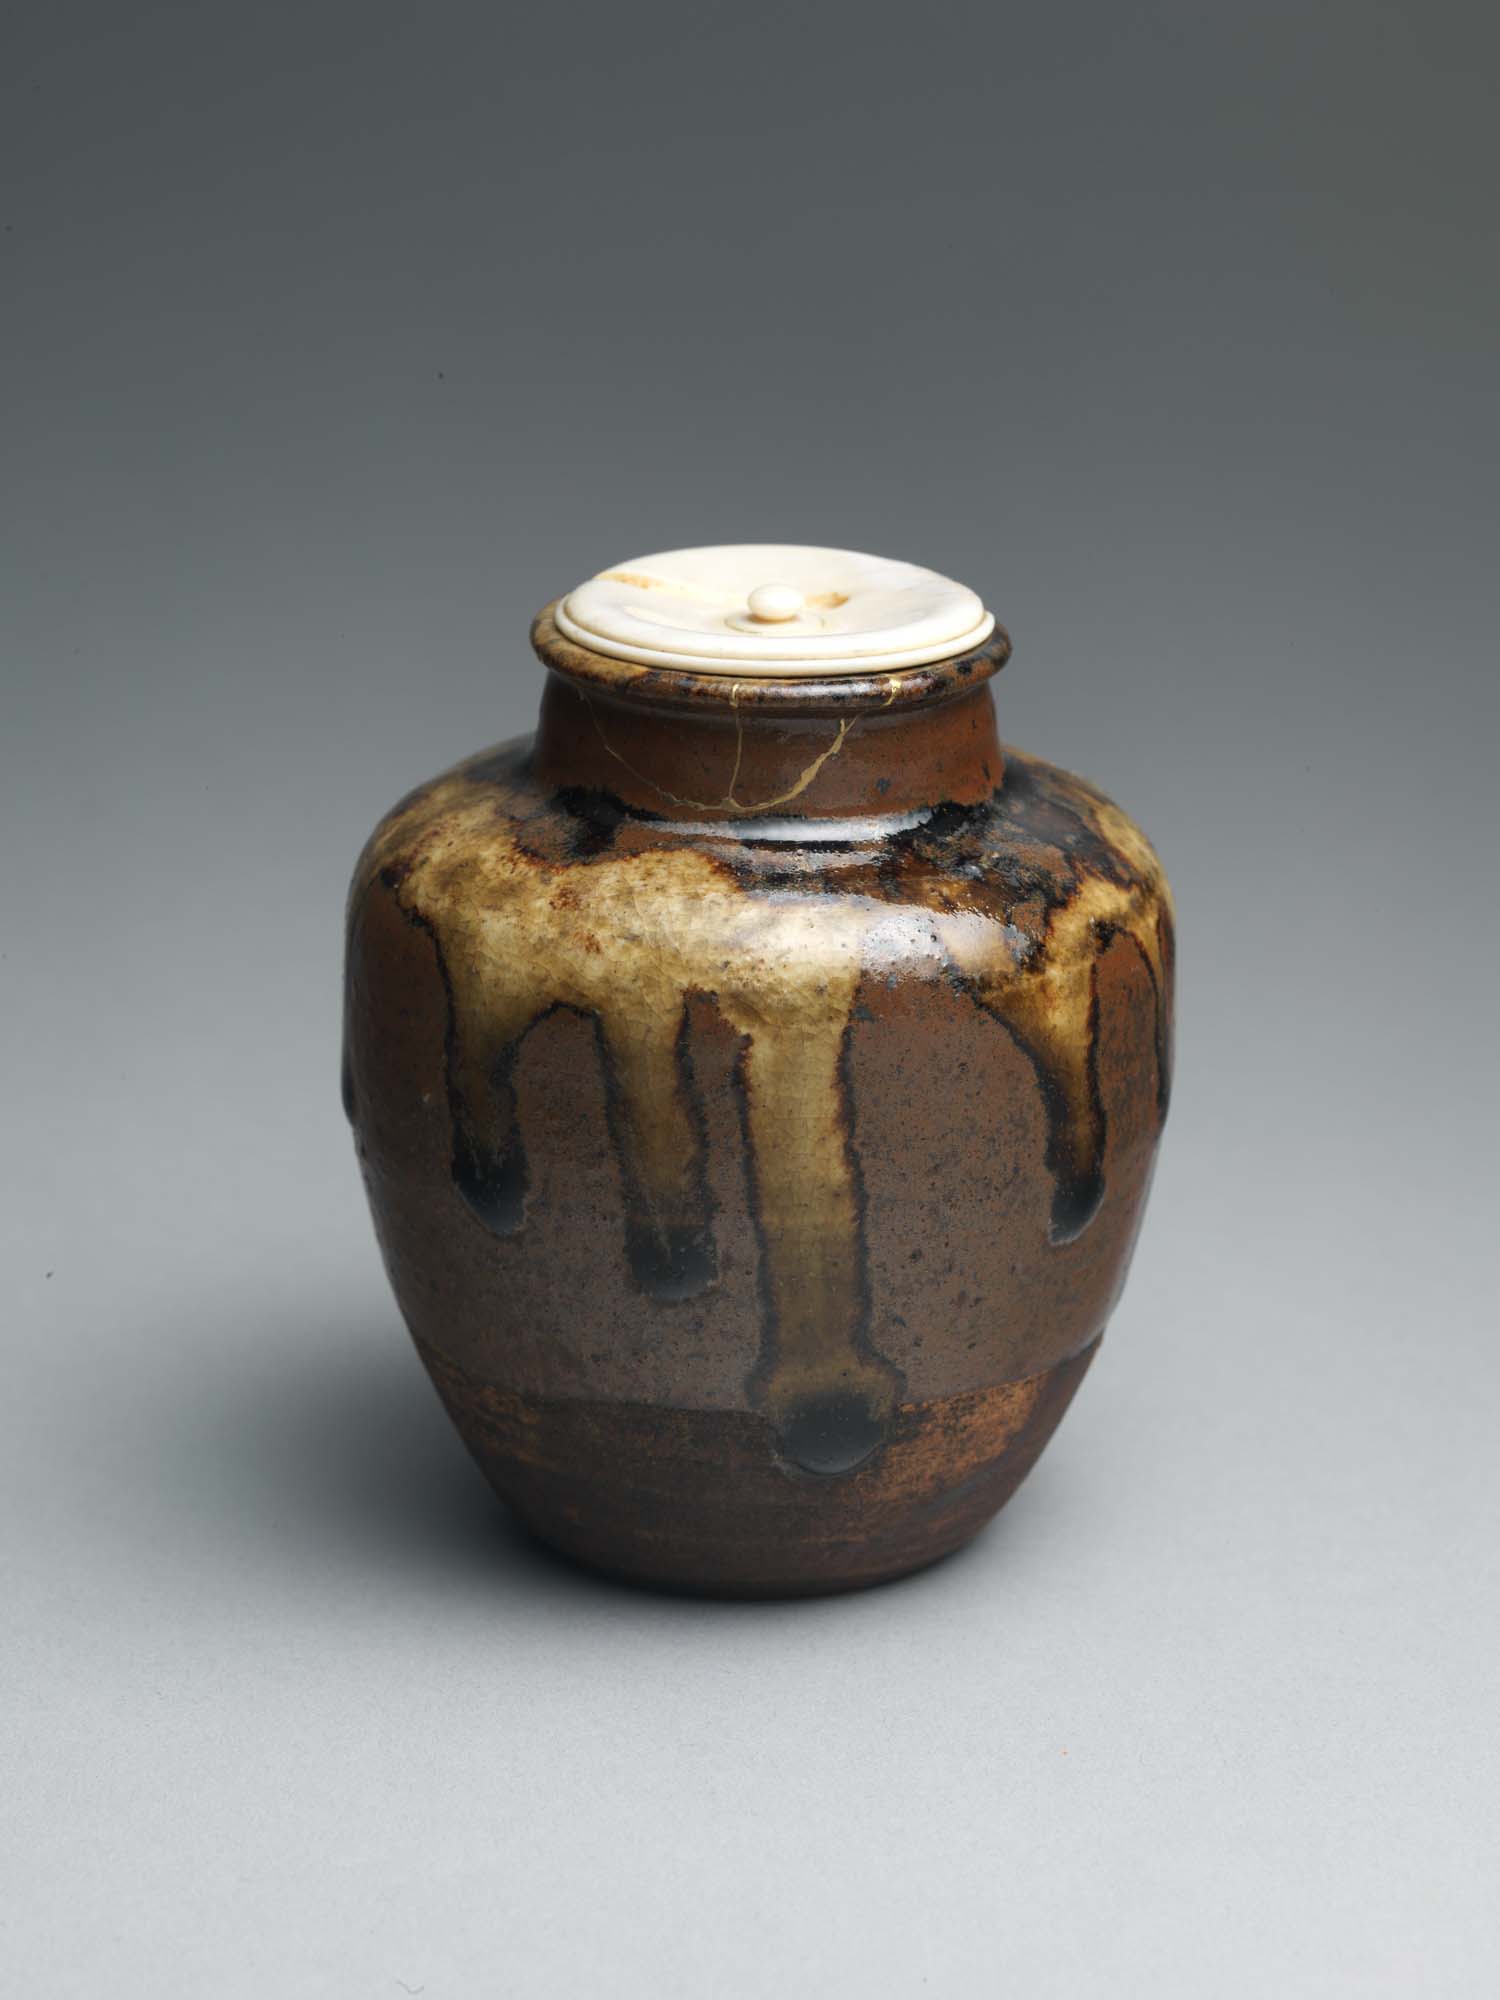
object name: tea jar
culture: japanese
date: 1701-1800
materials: clay, glaze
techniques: overglaze